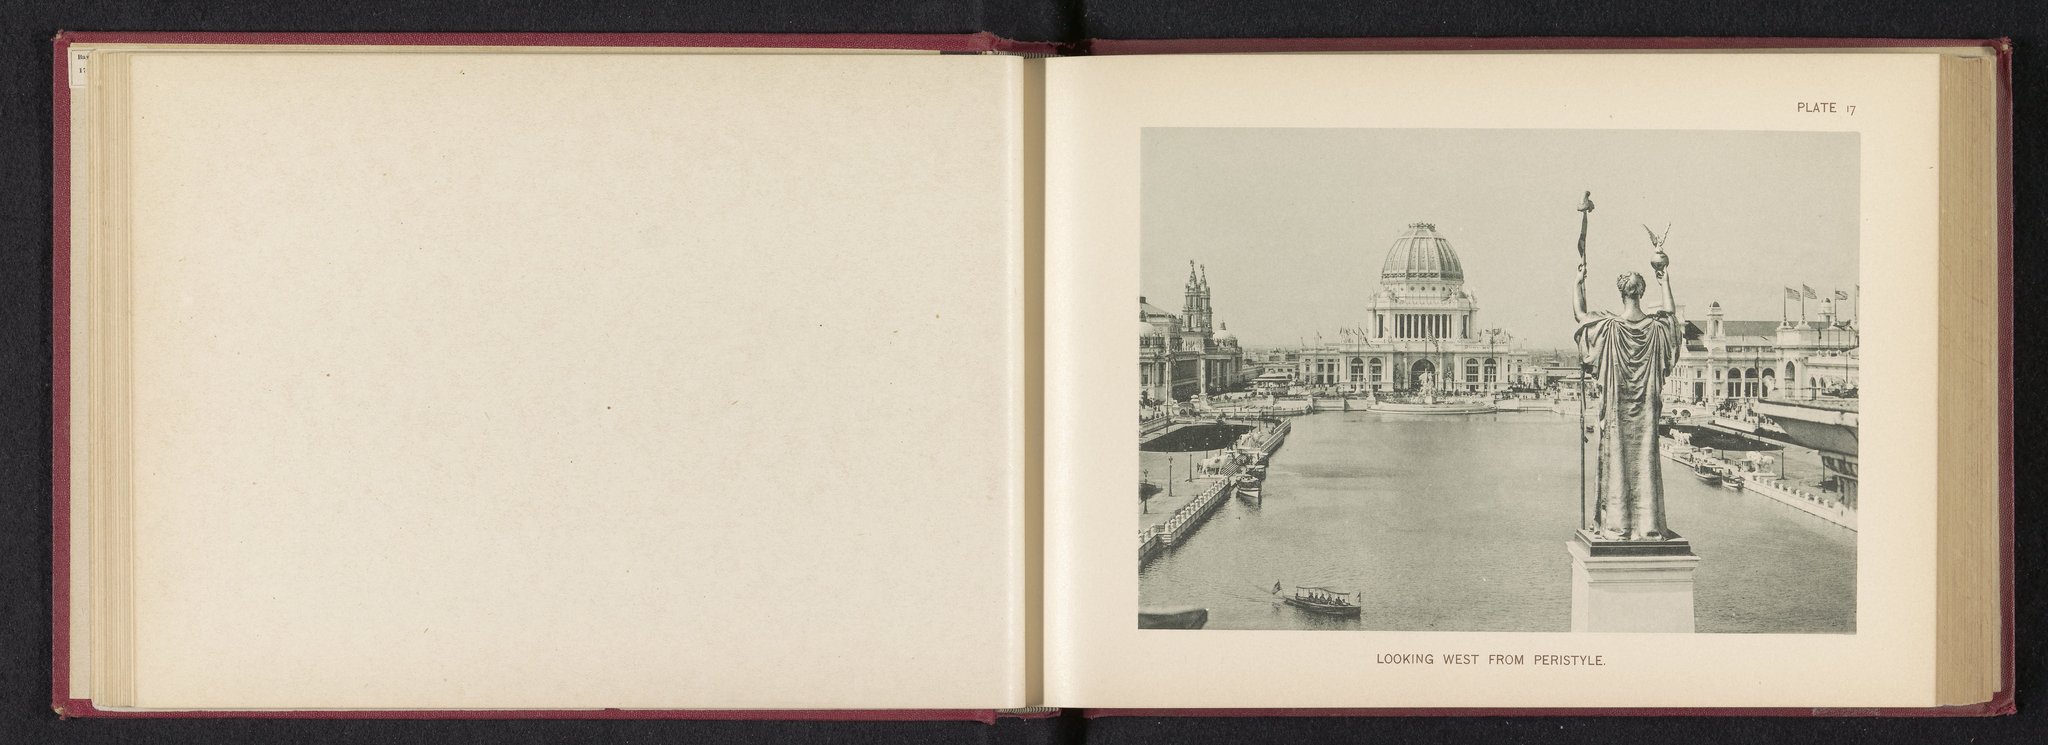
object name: page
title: Looking west from peristyle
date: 1893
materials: paper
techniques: photograph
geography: chicago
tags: world fair, world exhibition, piece of sculpture, reproduction of a piece of sculpture, pond, pool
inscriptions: number: ‘Plate 17’